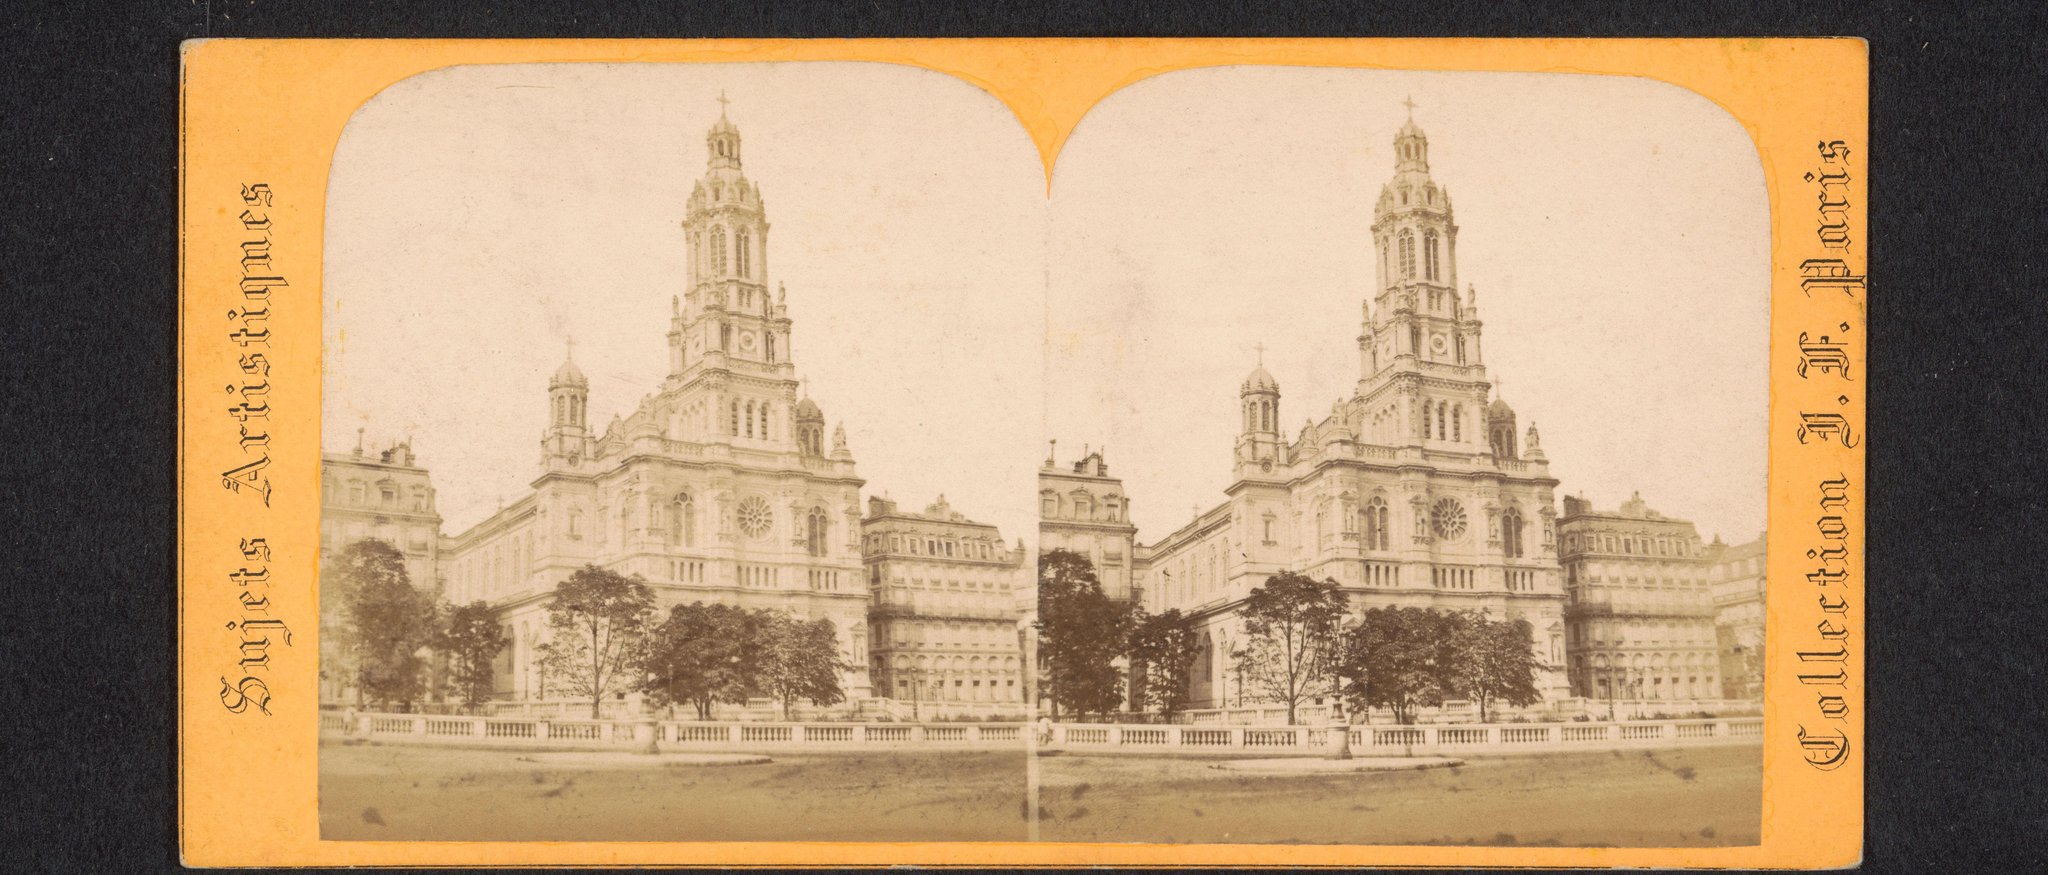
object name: stereograph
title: Gezicht op de Sainte-Trinité in Parijs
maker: jf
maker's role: fotograaf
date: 1850-1880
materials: cardboard, photographic support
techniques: albumen print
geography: paris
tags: church (exterior)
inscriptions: inscription: ‘Trinite’, number: ‘13832.’